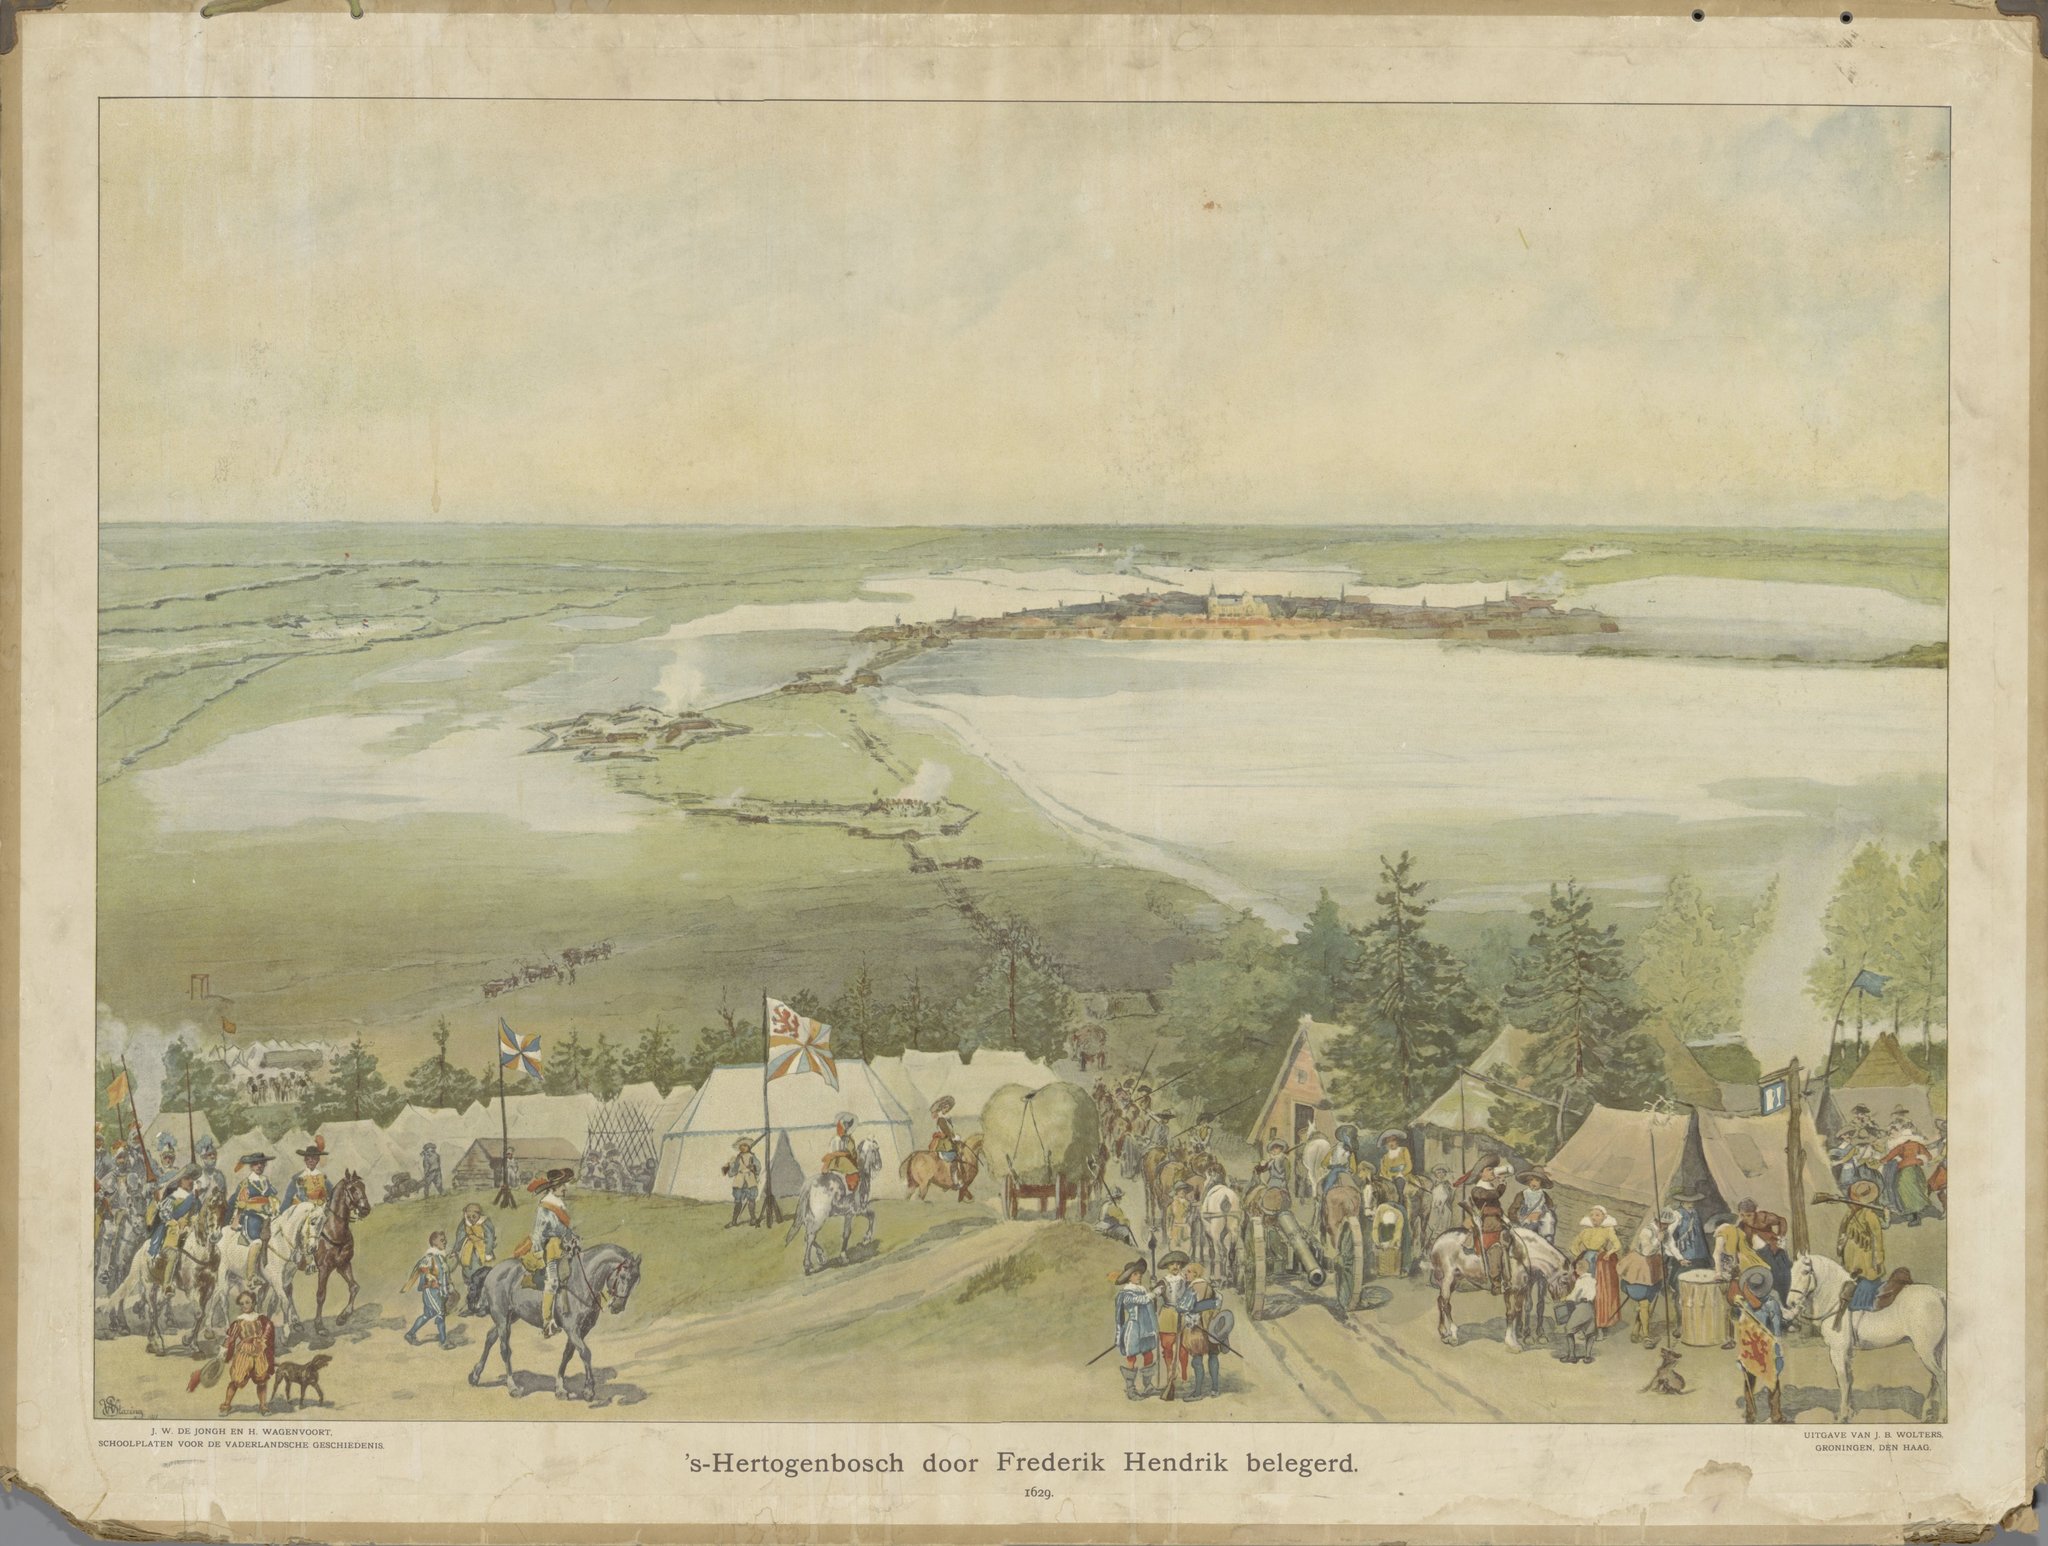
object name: schoolplaat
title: 's-Hertogenbosch door Frederik Hendrik belegerd 1629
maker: willem constantijn staring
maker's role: draughtsman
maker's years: 1847-1916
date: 1911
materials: cardboard, paper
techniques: printing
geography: netherlands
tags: netherlands, den bosch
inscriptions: date